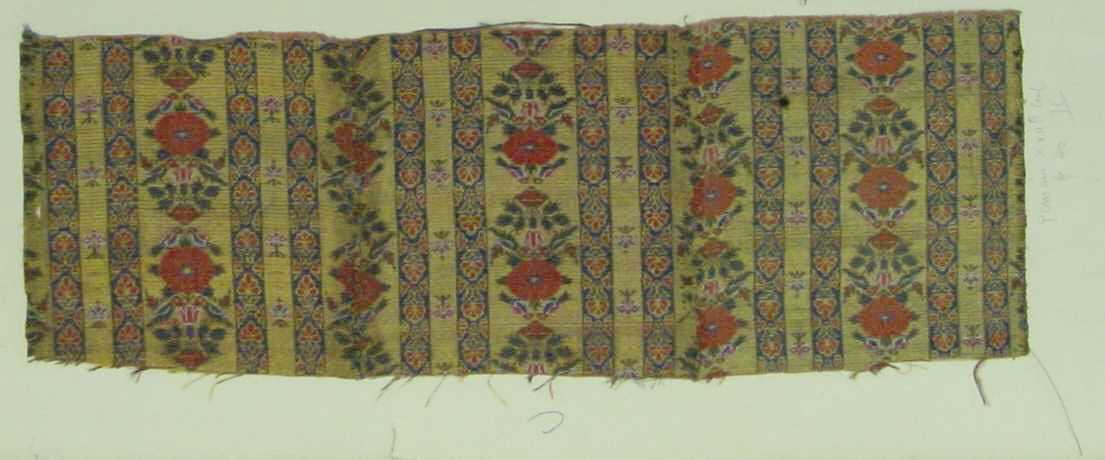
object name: textile fragment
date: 1601-1700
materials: metal thread, silk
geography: iran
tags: flowers